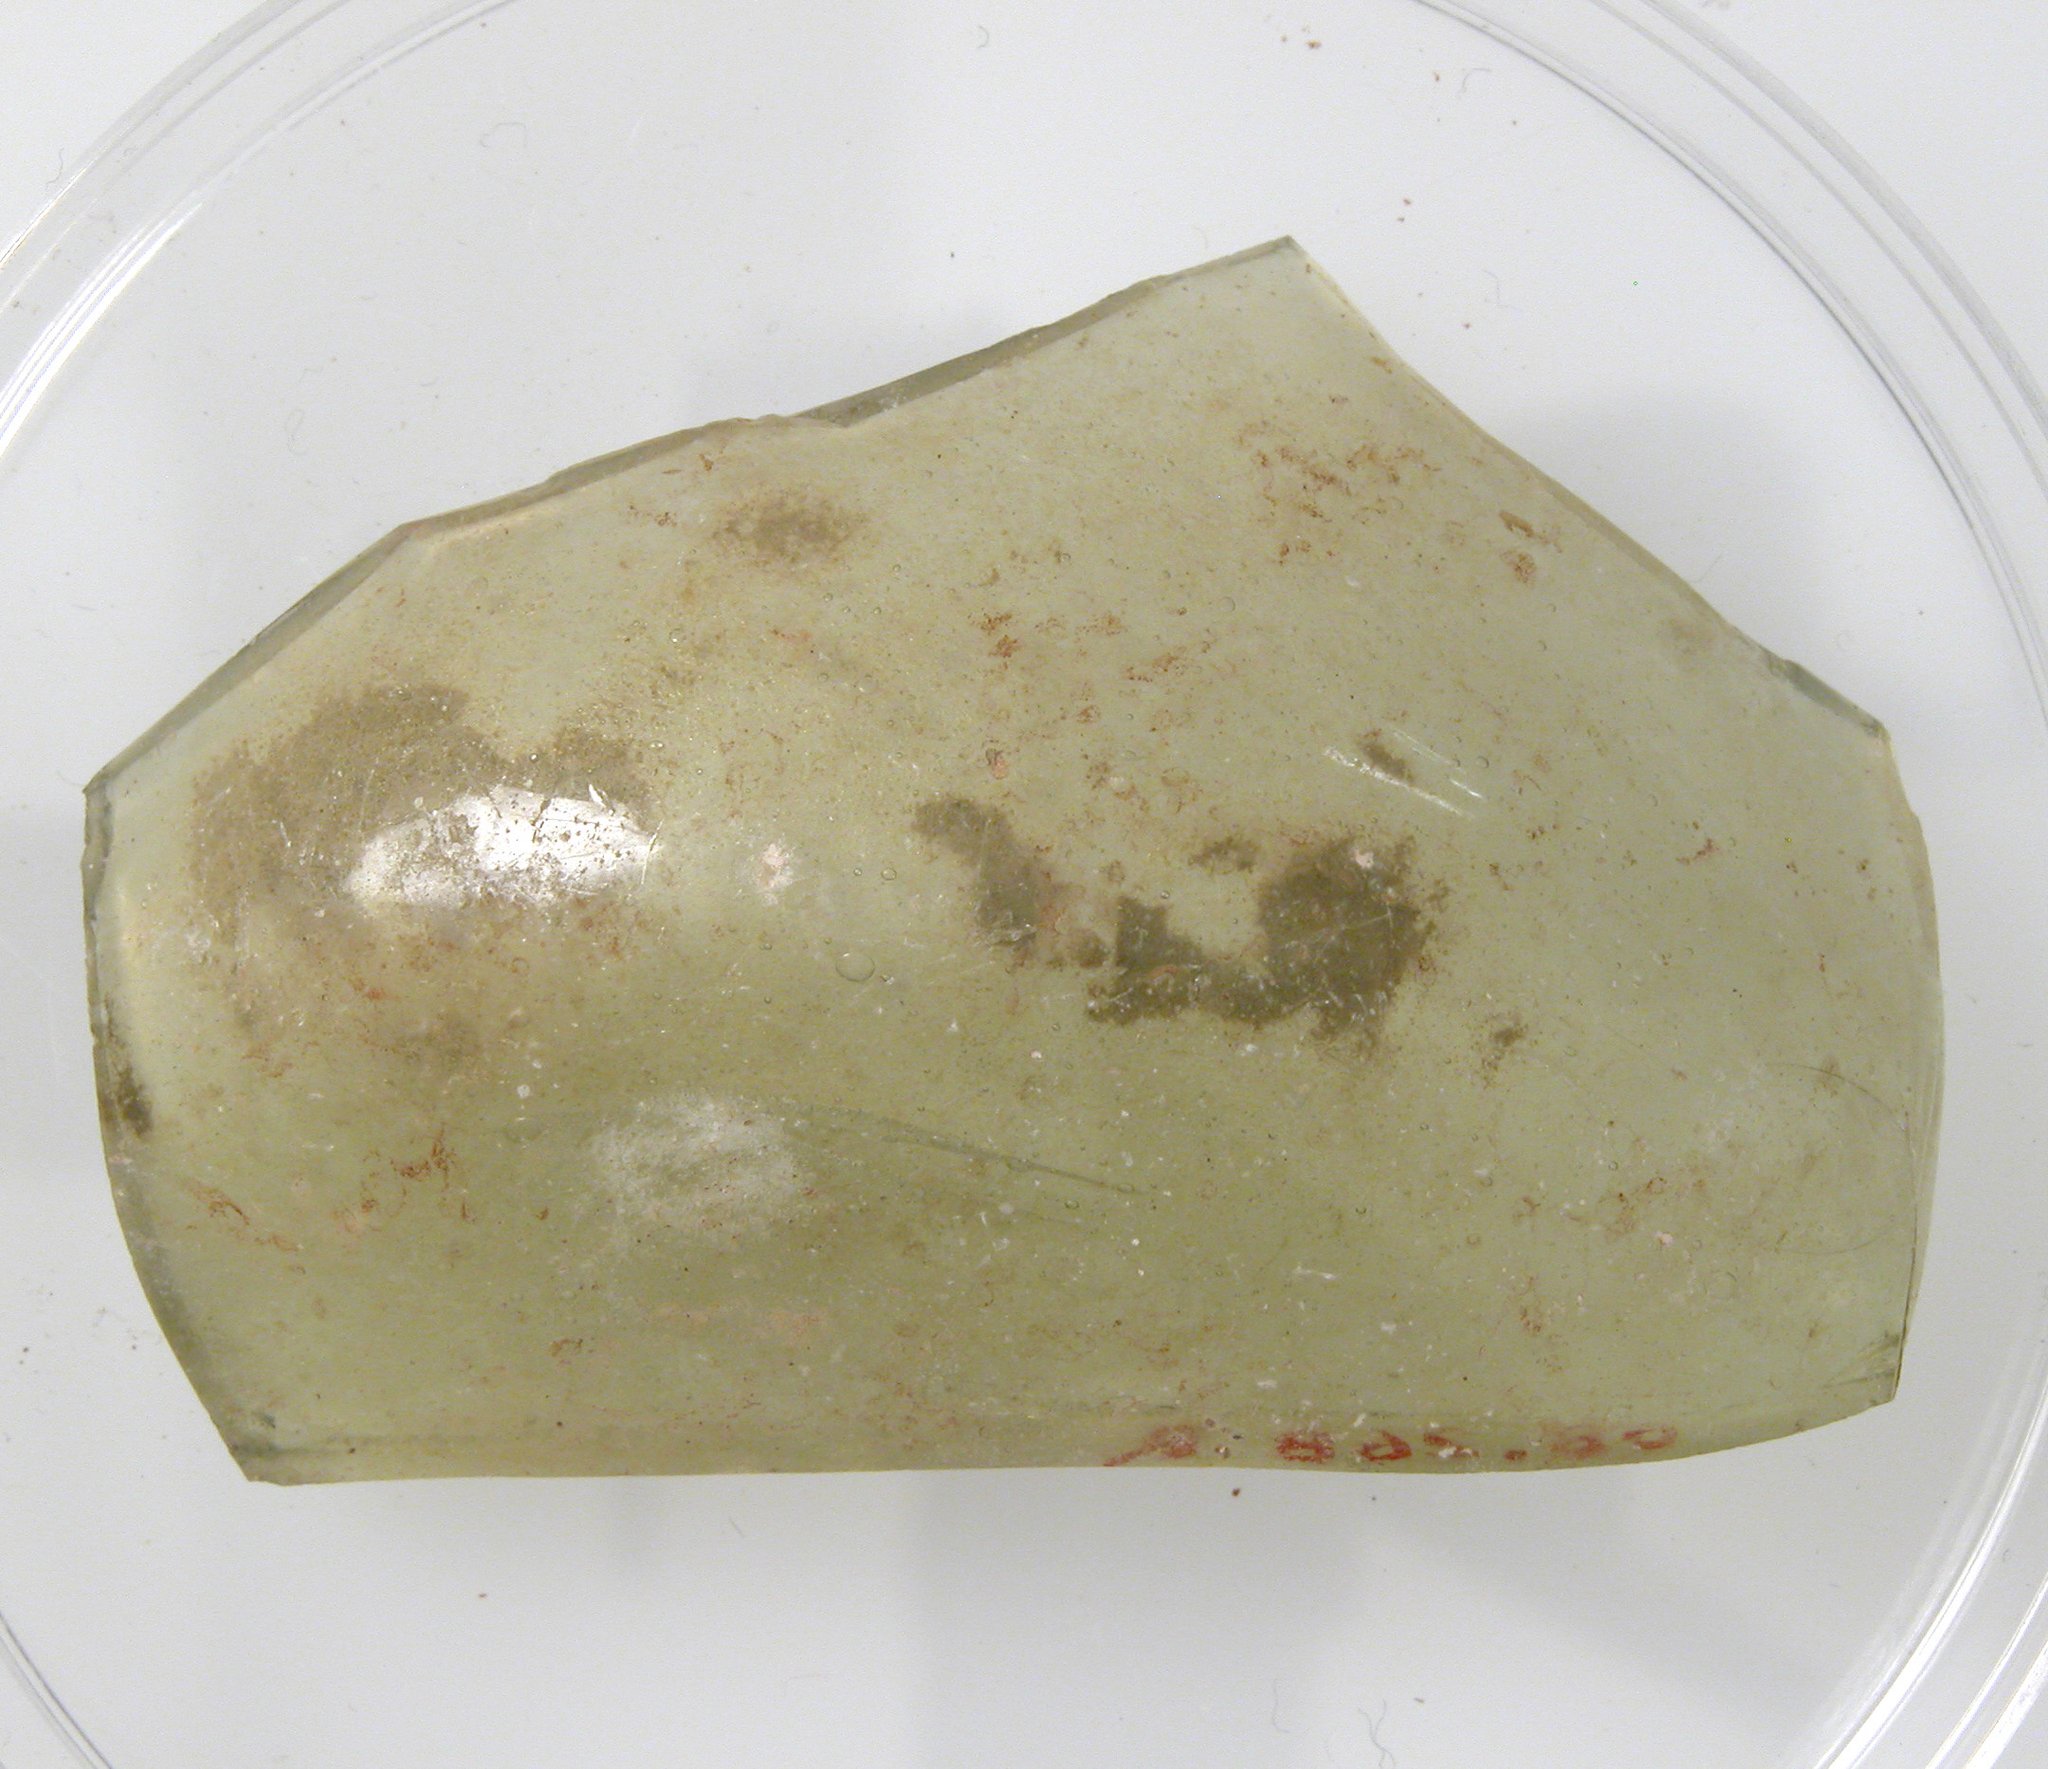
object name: fragment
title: Glass Fragment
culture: coptic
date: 301-433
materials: glass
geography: egypt